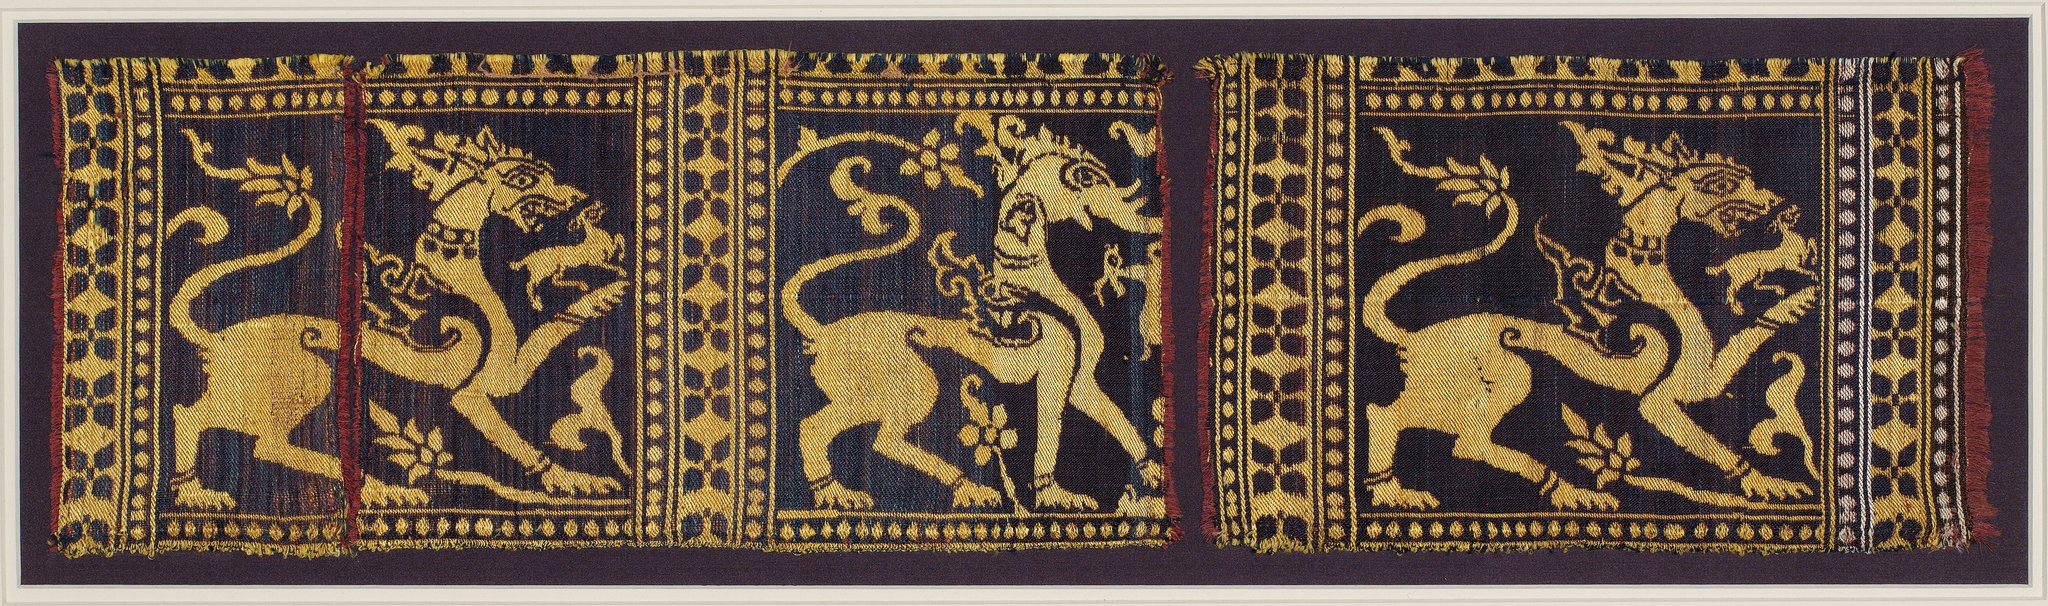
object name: textile fragment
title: Textile Fragments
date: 1401-1600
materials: silk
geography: india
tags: mythical creatures